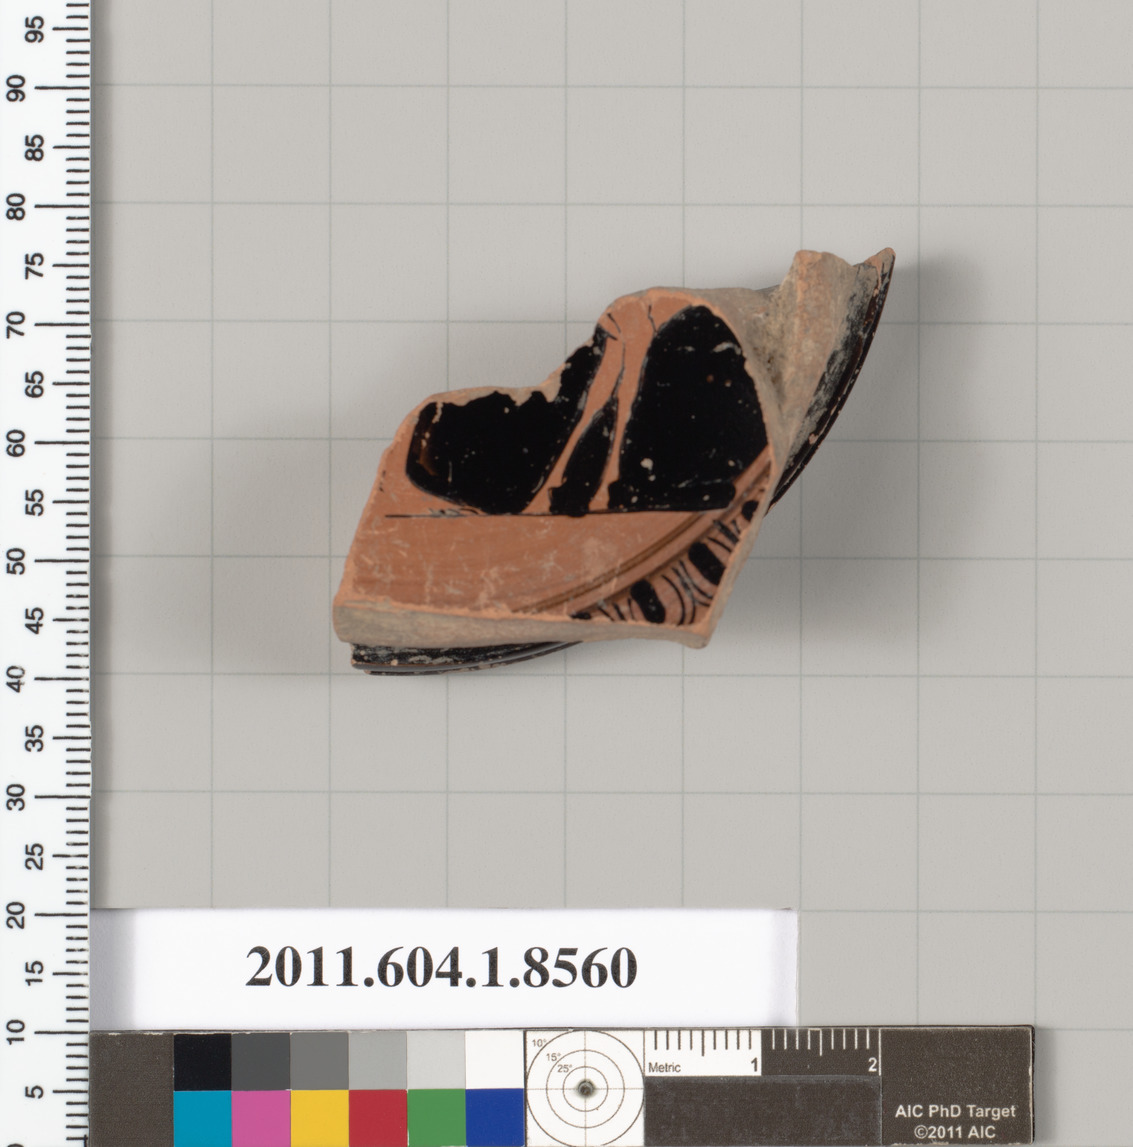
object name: kylix fragment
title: Terracotta fragment of a stemless kylix (drinking cup)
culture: greek, attic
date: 460-450 BCE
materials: terracotta